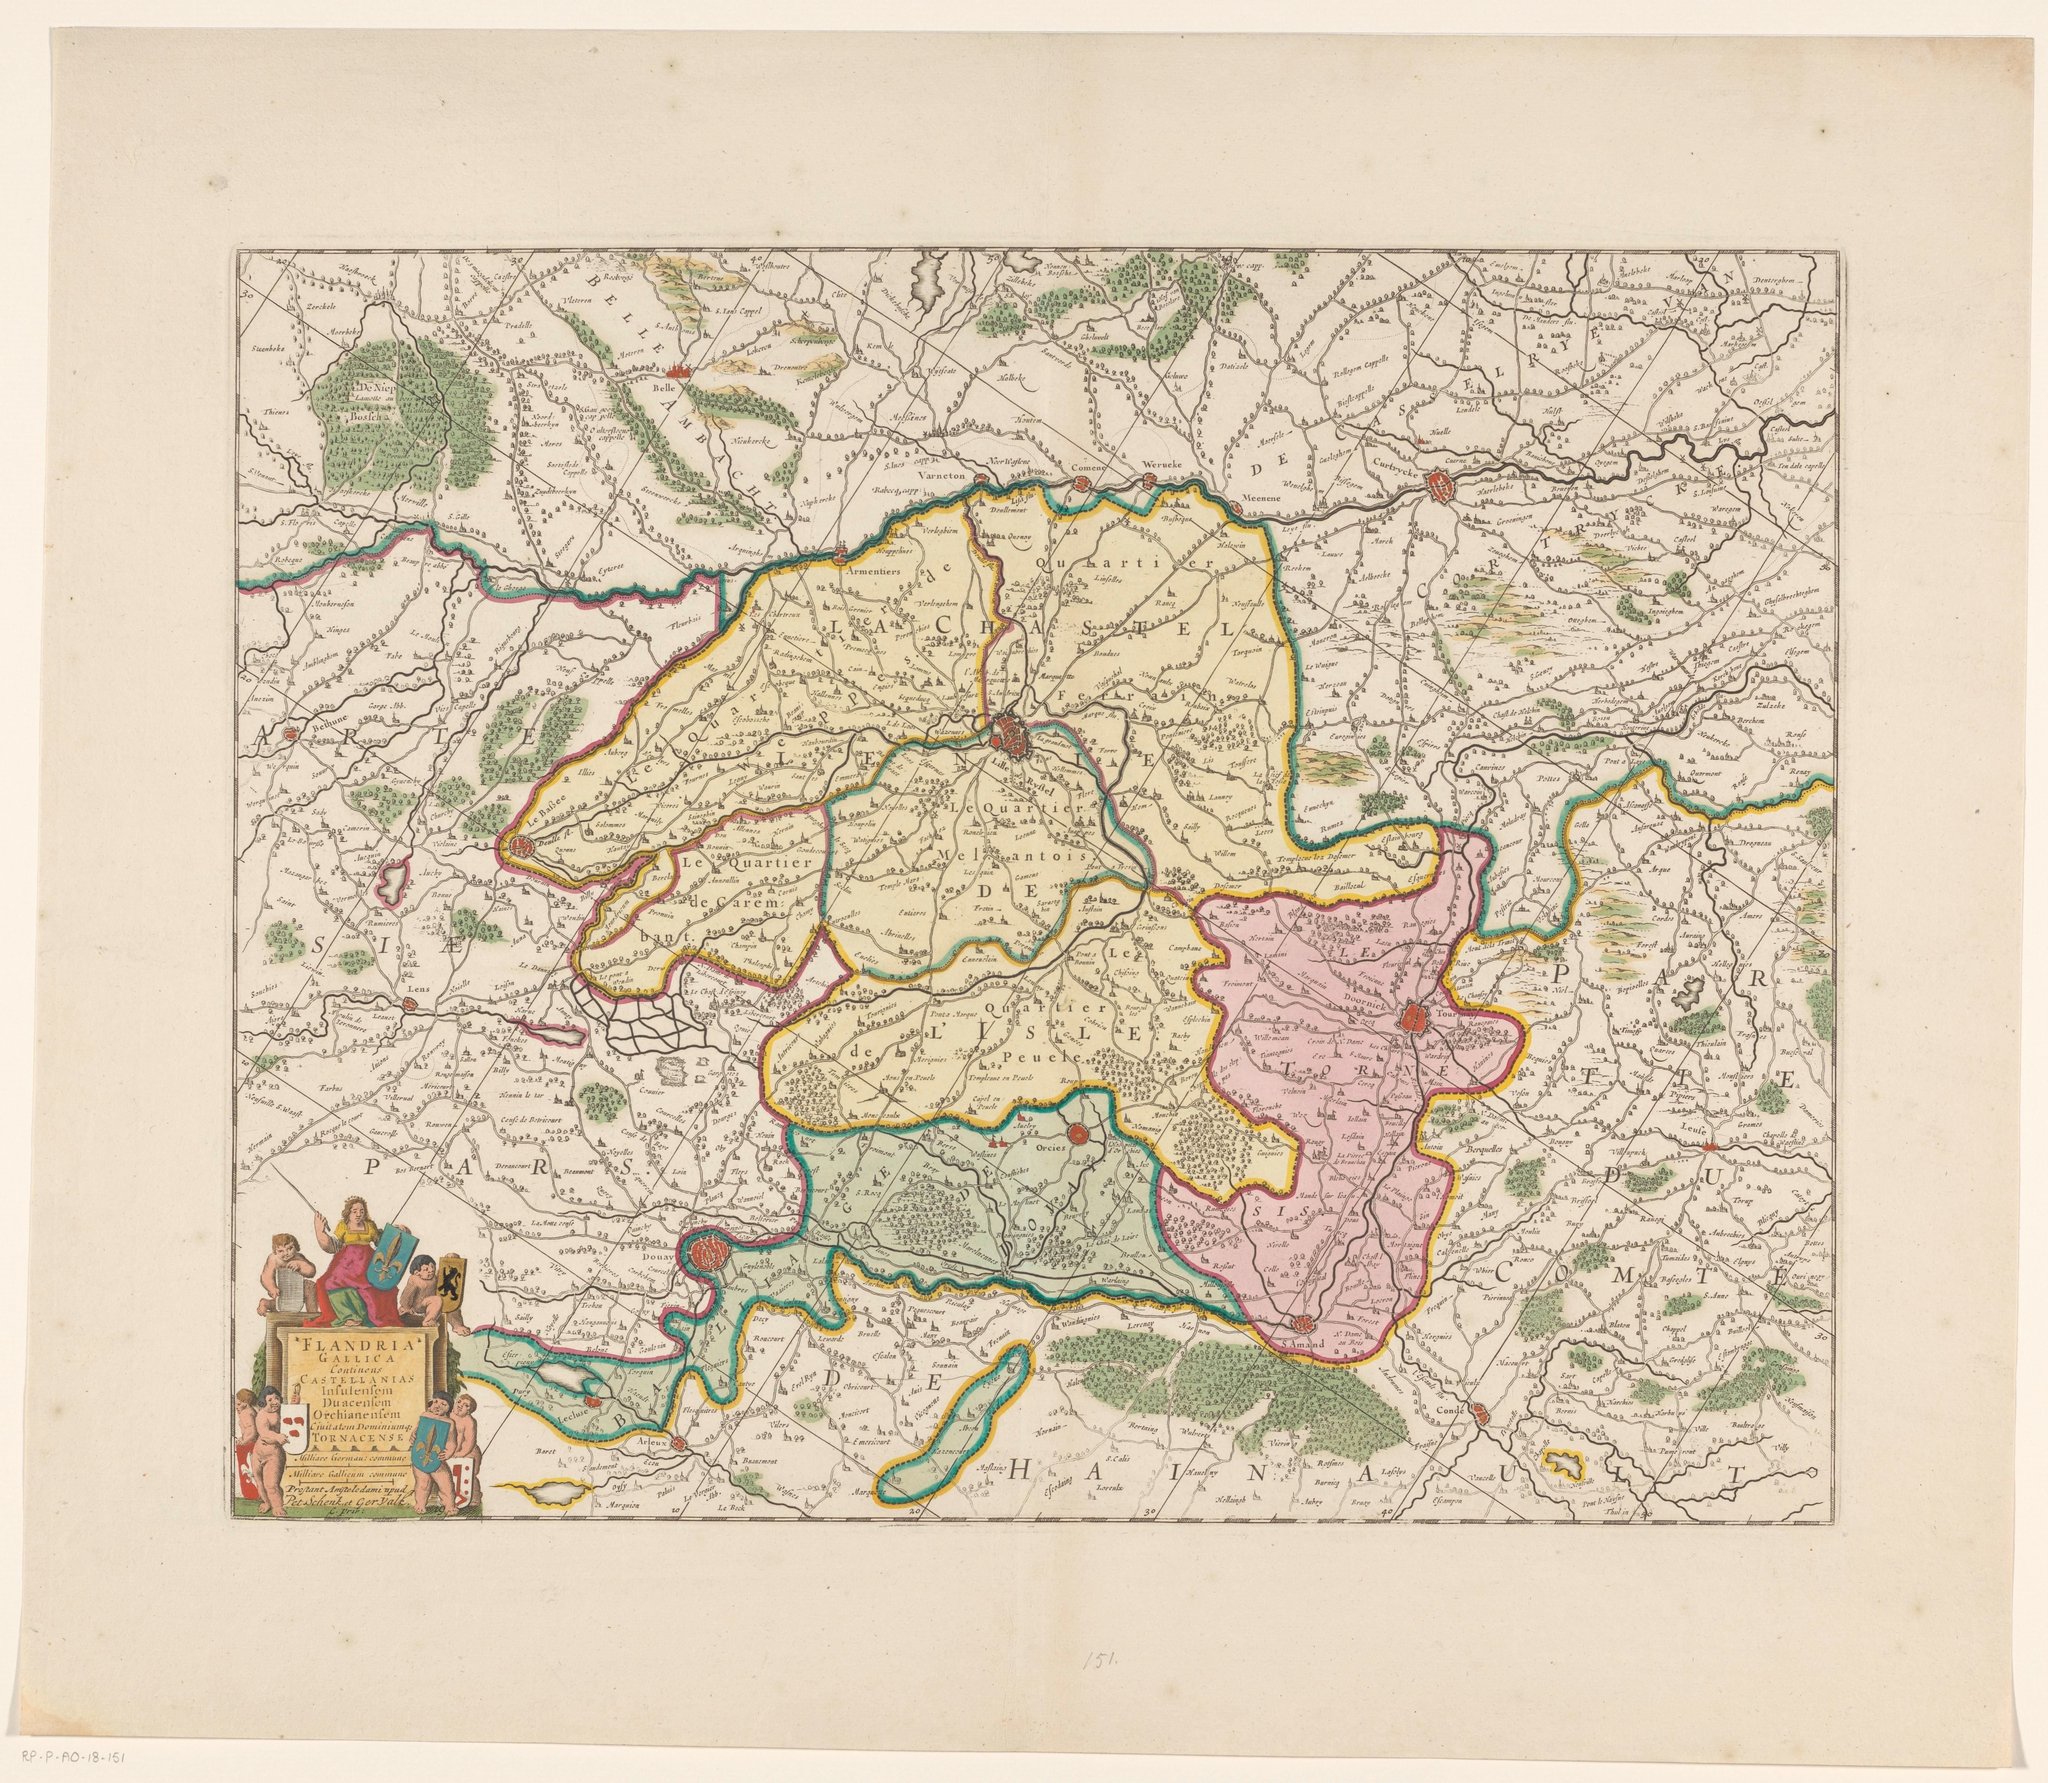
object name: map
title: Flandria Gallica continens castellanias Insulensum (...)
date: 1633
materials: paper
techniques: engraving, etching, hand coloring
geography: amsterdam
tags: coat of arms (as symbol of the state, etc.) (+ city; municipal), maps of separate countries or regions, coat of arms (as symbol of the state, etc.) (+ province; provincial), lille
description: Kaart van Frans-Vlaanderen. Linksonder de titelcartouche, met bovenin een figuur met het wapen van Lille, en om de cartouche heen figuren met de wapens van kasselrijen in Frans-Vlaanderen. Onderin de cartouche twee schaalstokken: Milliarie Germau: commune / Milliare Gallicum commune. De kaart is voorzien van een coördinaten-net en een gradenverdeling langs de randen.